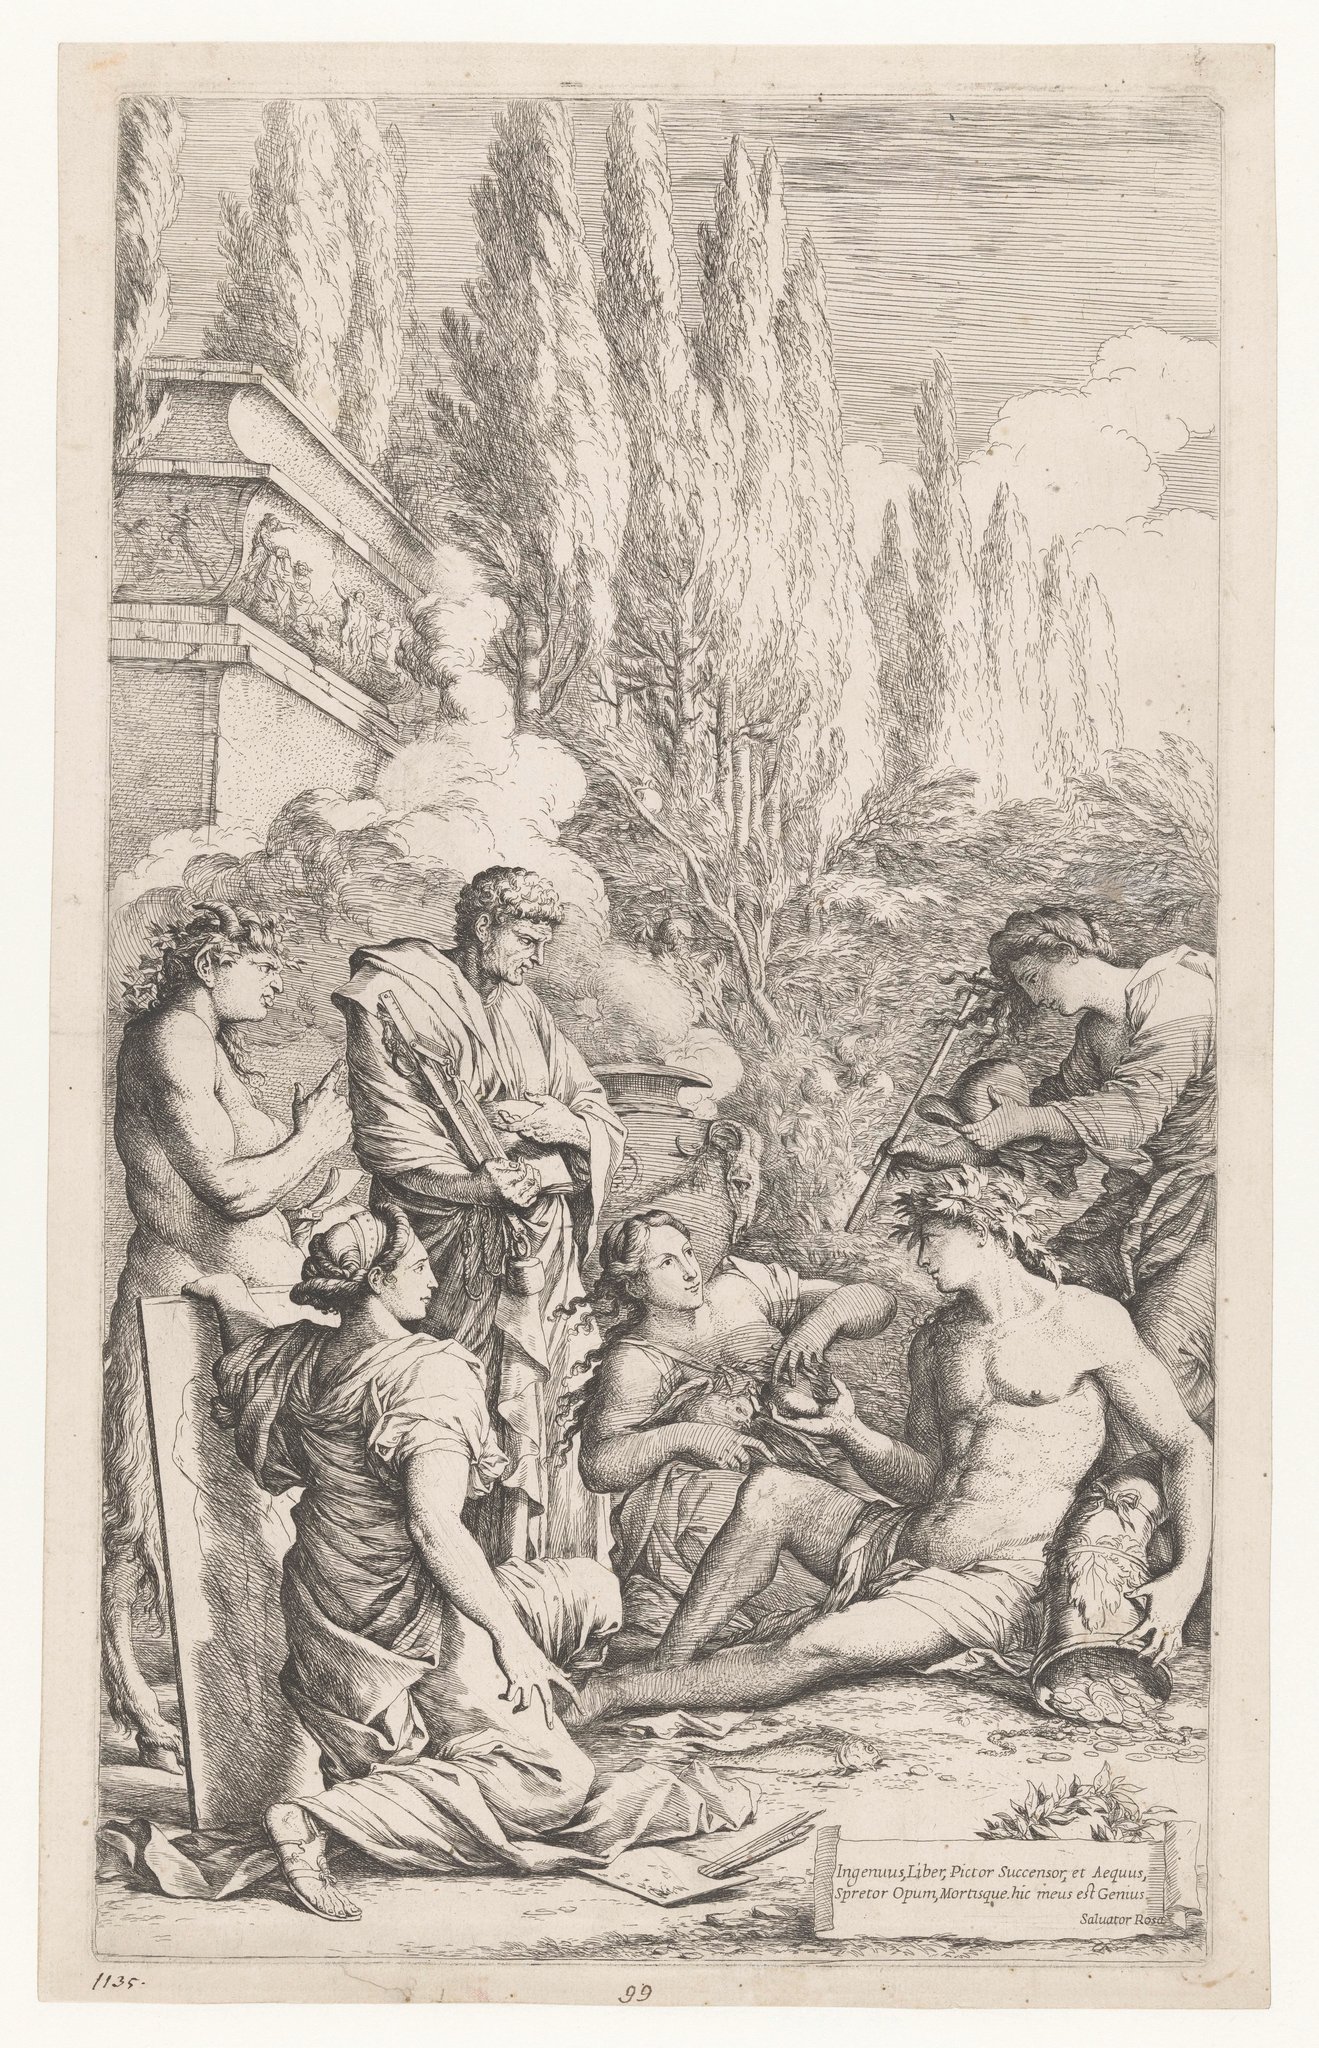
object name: print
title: De genius van Salvator Rosa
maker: salvator rosa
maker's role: draughtsman, painter, print maker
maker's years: 1615-1673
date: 1662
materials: paper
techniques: drypoint, etching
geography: italy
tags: 'pictura', symbolic representations, allegories and emblems ~ painting; 'pittura' (ripa), genius, portrait, self-portrait of painter, sarcophagus, freedom, liberty; 'libertà' (ripa), equality, equity, fairness, righteousness; 'equalità', 'equità', 'giuditio giusto', 'ordine dritto e giusto', 'ugualità' (ripa)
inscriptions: number: ‘1135 99’, collector's mark: Lugt 240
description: Salvator Rosa zit rechts op de grond met zijn hand rustend op een hoorn des overvloeds (cornucopia). Met zijn andere hand geeft hij zijn hart aan Eerlijkheid (Sinceritas), een vrouwelijke figuur met een duif. Rechts achter de kunstenaar staat Vrijheid (Libertas). Links op de voorgrond knielt Schilderkunst (Pictura) met een schilderij en schilderspalet en voor haar op de grond een vis. Achter haar staan een sater en Gelijkheid (Aequitas), in toga gekleed. Op de achtergrond een sarcofaag. Rechtsonder twee regels Latijnse tekst.